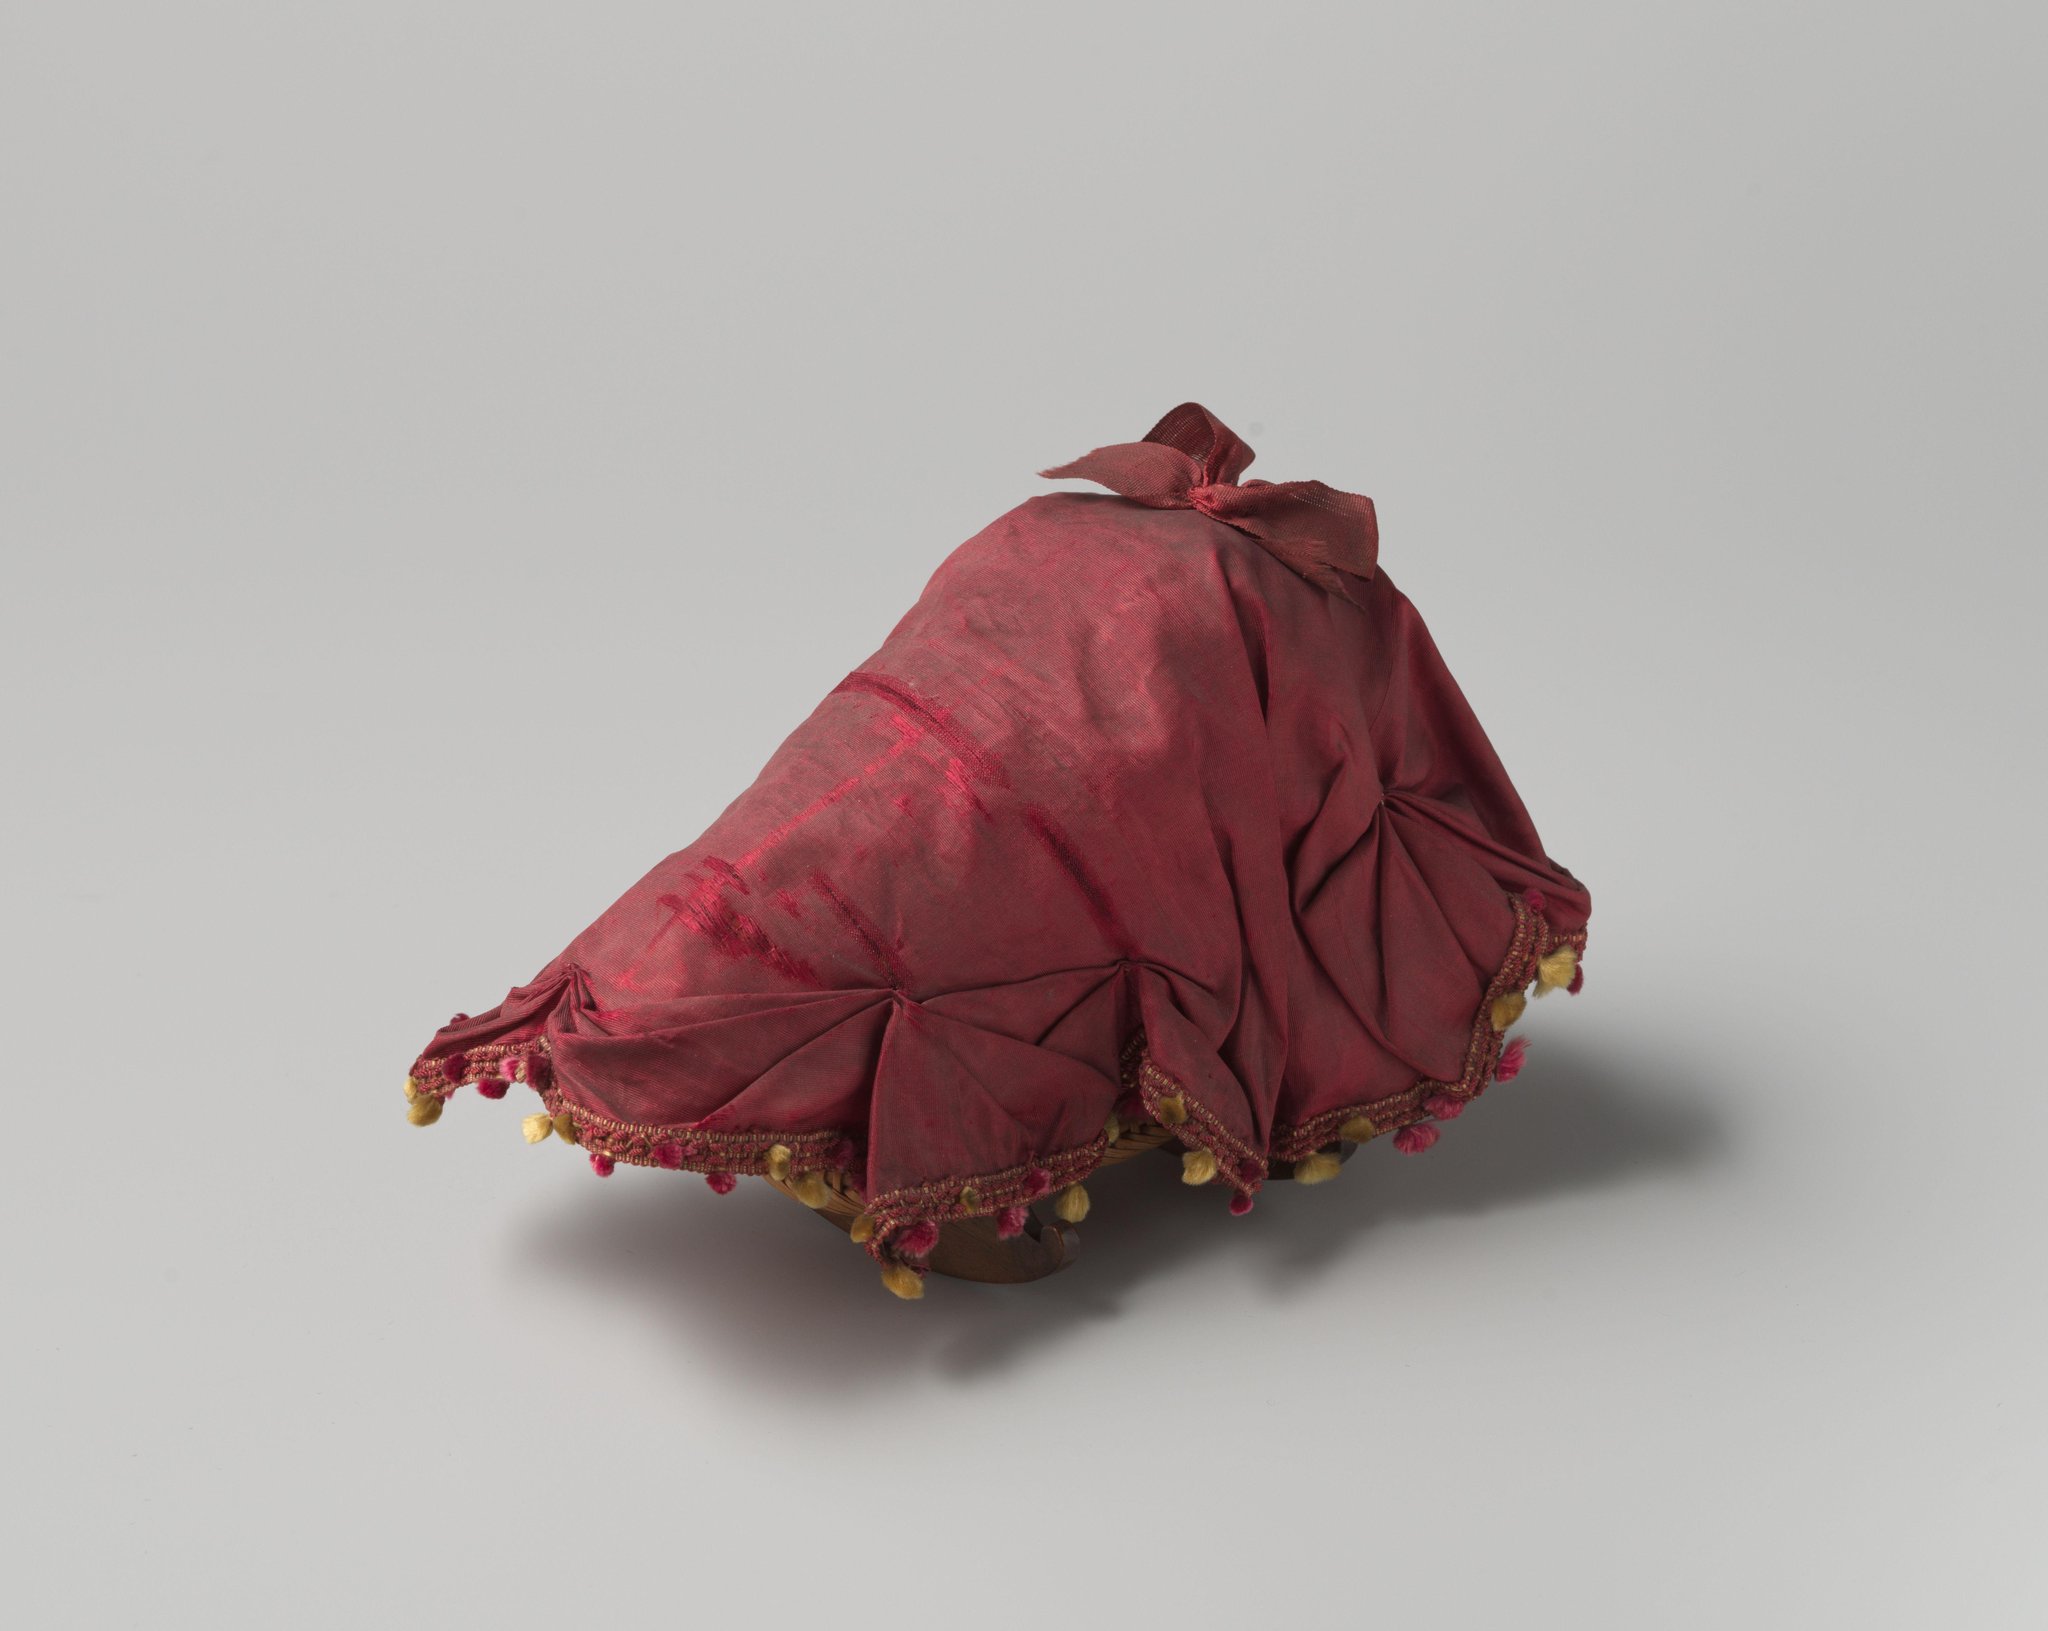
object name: miniature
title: Wiegekleed, vervaardigd van rode moire zijde, afgezet met passement met afwisselend rode en gele kwastjes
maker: Anonymous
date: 1690-1710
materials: silk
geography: amsterdam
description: Wiegekleed, gemaakt van rode moiré zijde. afgezet met passement met afwisselend rode en gele kwastjes. Het kleed is geconstrueerd uit een rechthoekige lap stof, waarvan de randen op acht plaatsen zo zijn opgenomen en inploeien vastgezet, dat een bolle wiegvorm is ontstaan met draperieën. Boven op de kap is een rode zijden strik genaaid.